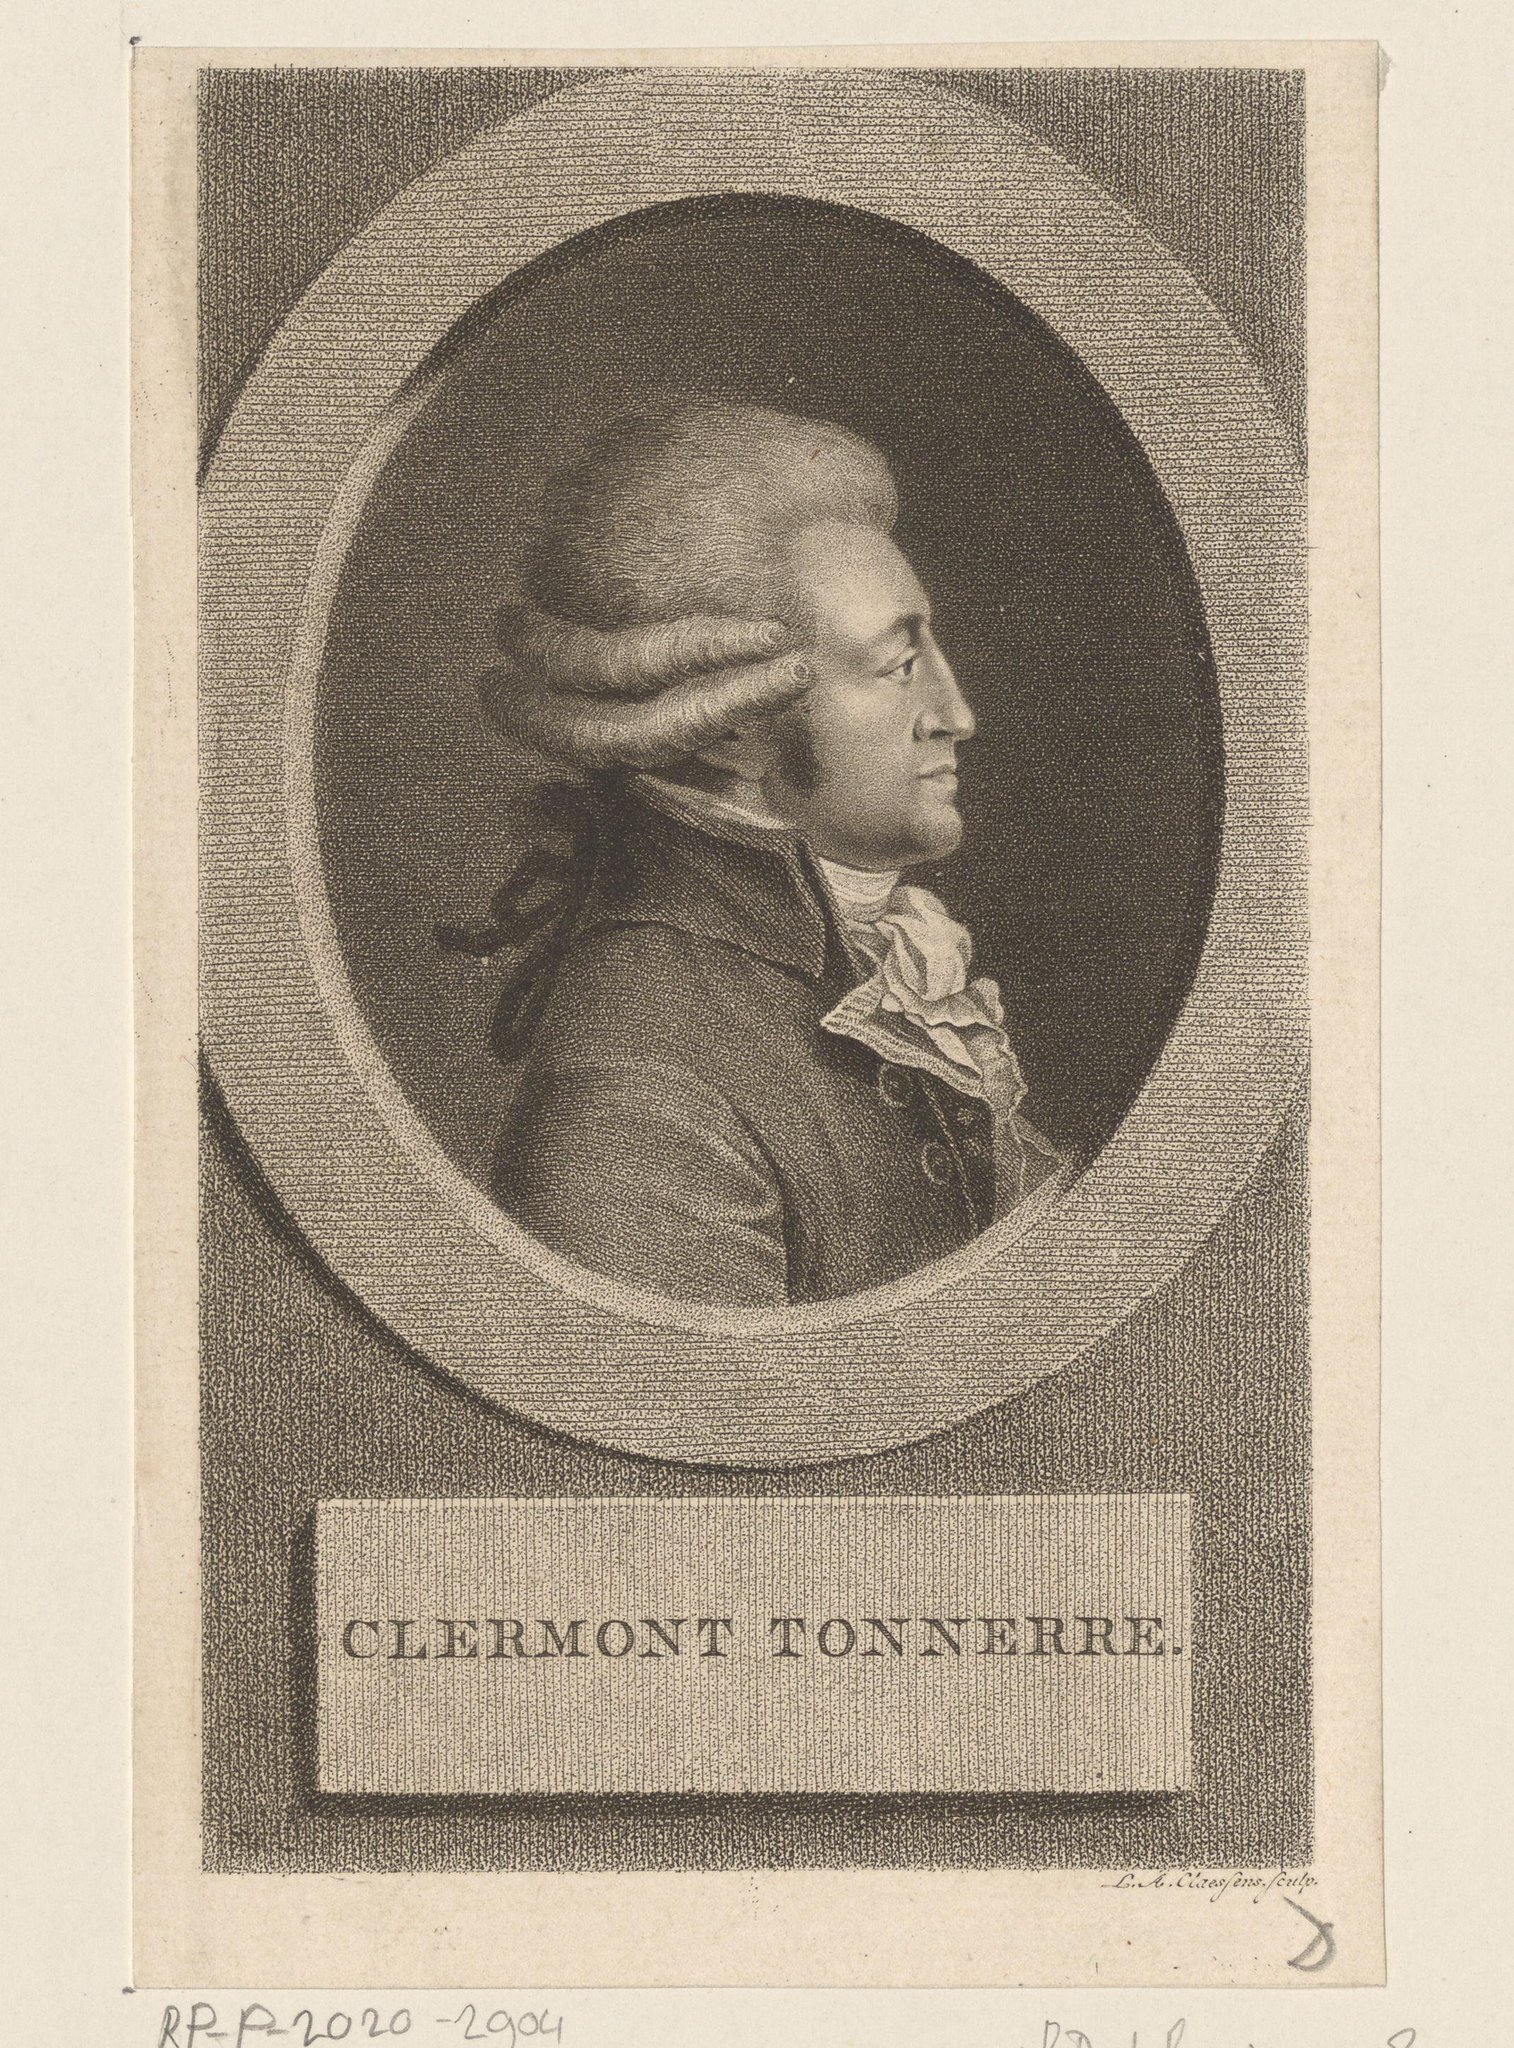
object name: print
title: Portret van Stanislas Marie Adélaïde, graaf van Clermont-Tonnerre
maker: lambertus antonius claessens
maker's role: draughtsman, print maker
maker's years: 1763-1834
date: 1777-1834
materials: paper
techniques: engraving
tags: politician, historical persons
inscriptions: collector's mark: Lugt 2282